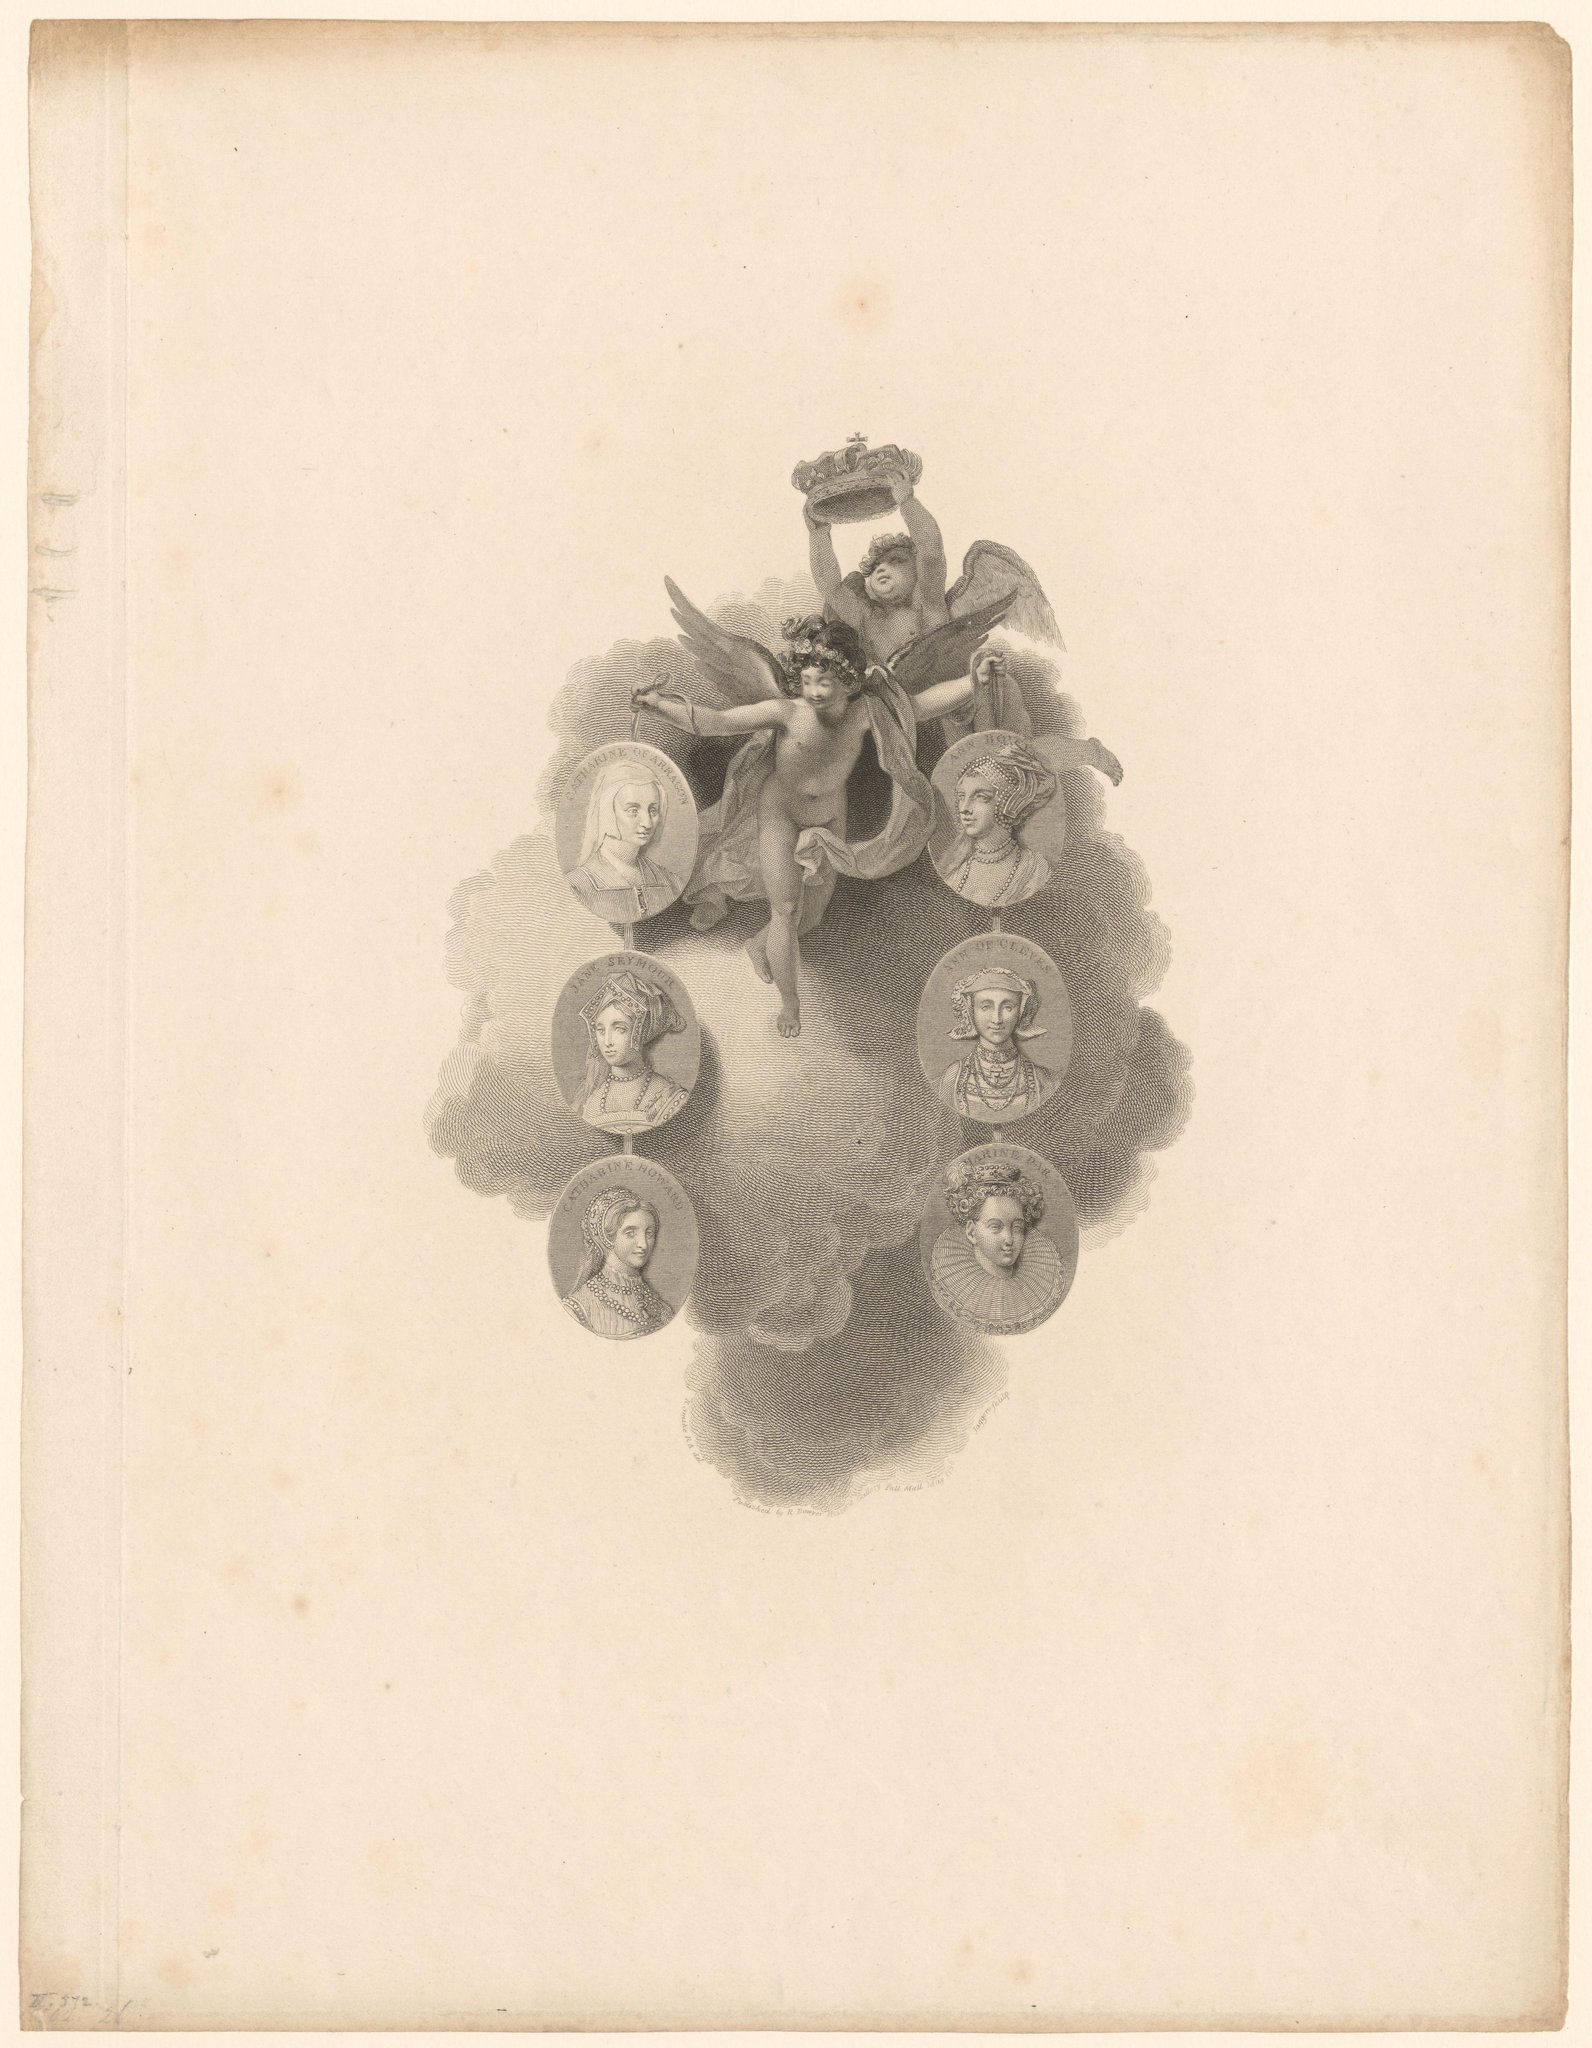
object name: print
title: Portretten van de zes echtgenotes van Hendrik VIII, koning van Engeland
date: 1796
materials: paper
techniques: engraving, etching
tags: london, historical persons, queen, marriage, married couple, 'matrimonium'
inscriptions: collector's mark: Lugt 2228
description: Deze prent is gebruikt in: The History of England. Londen: Robert Bowyer, 1796. Deze editie is gebaseerd op David Hume's uitgave van 'The History of England', waarvan het eerste deel verscheen in 1754 en het laatste in 1762.